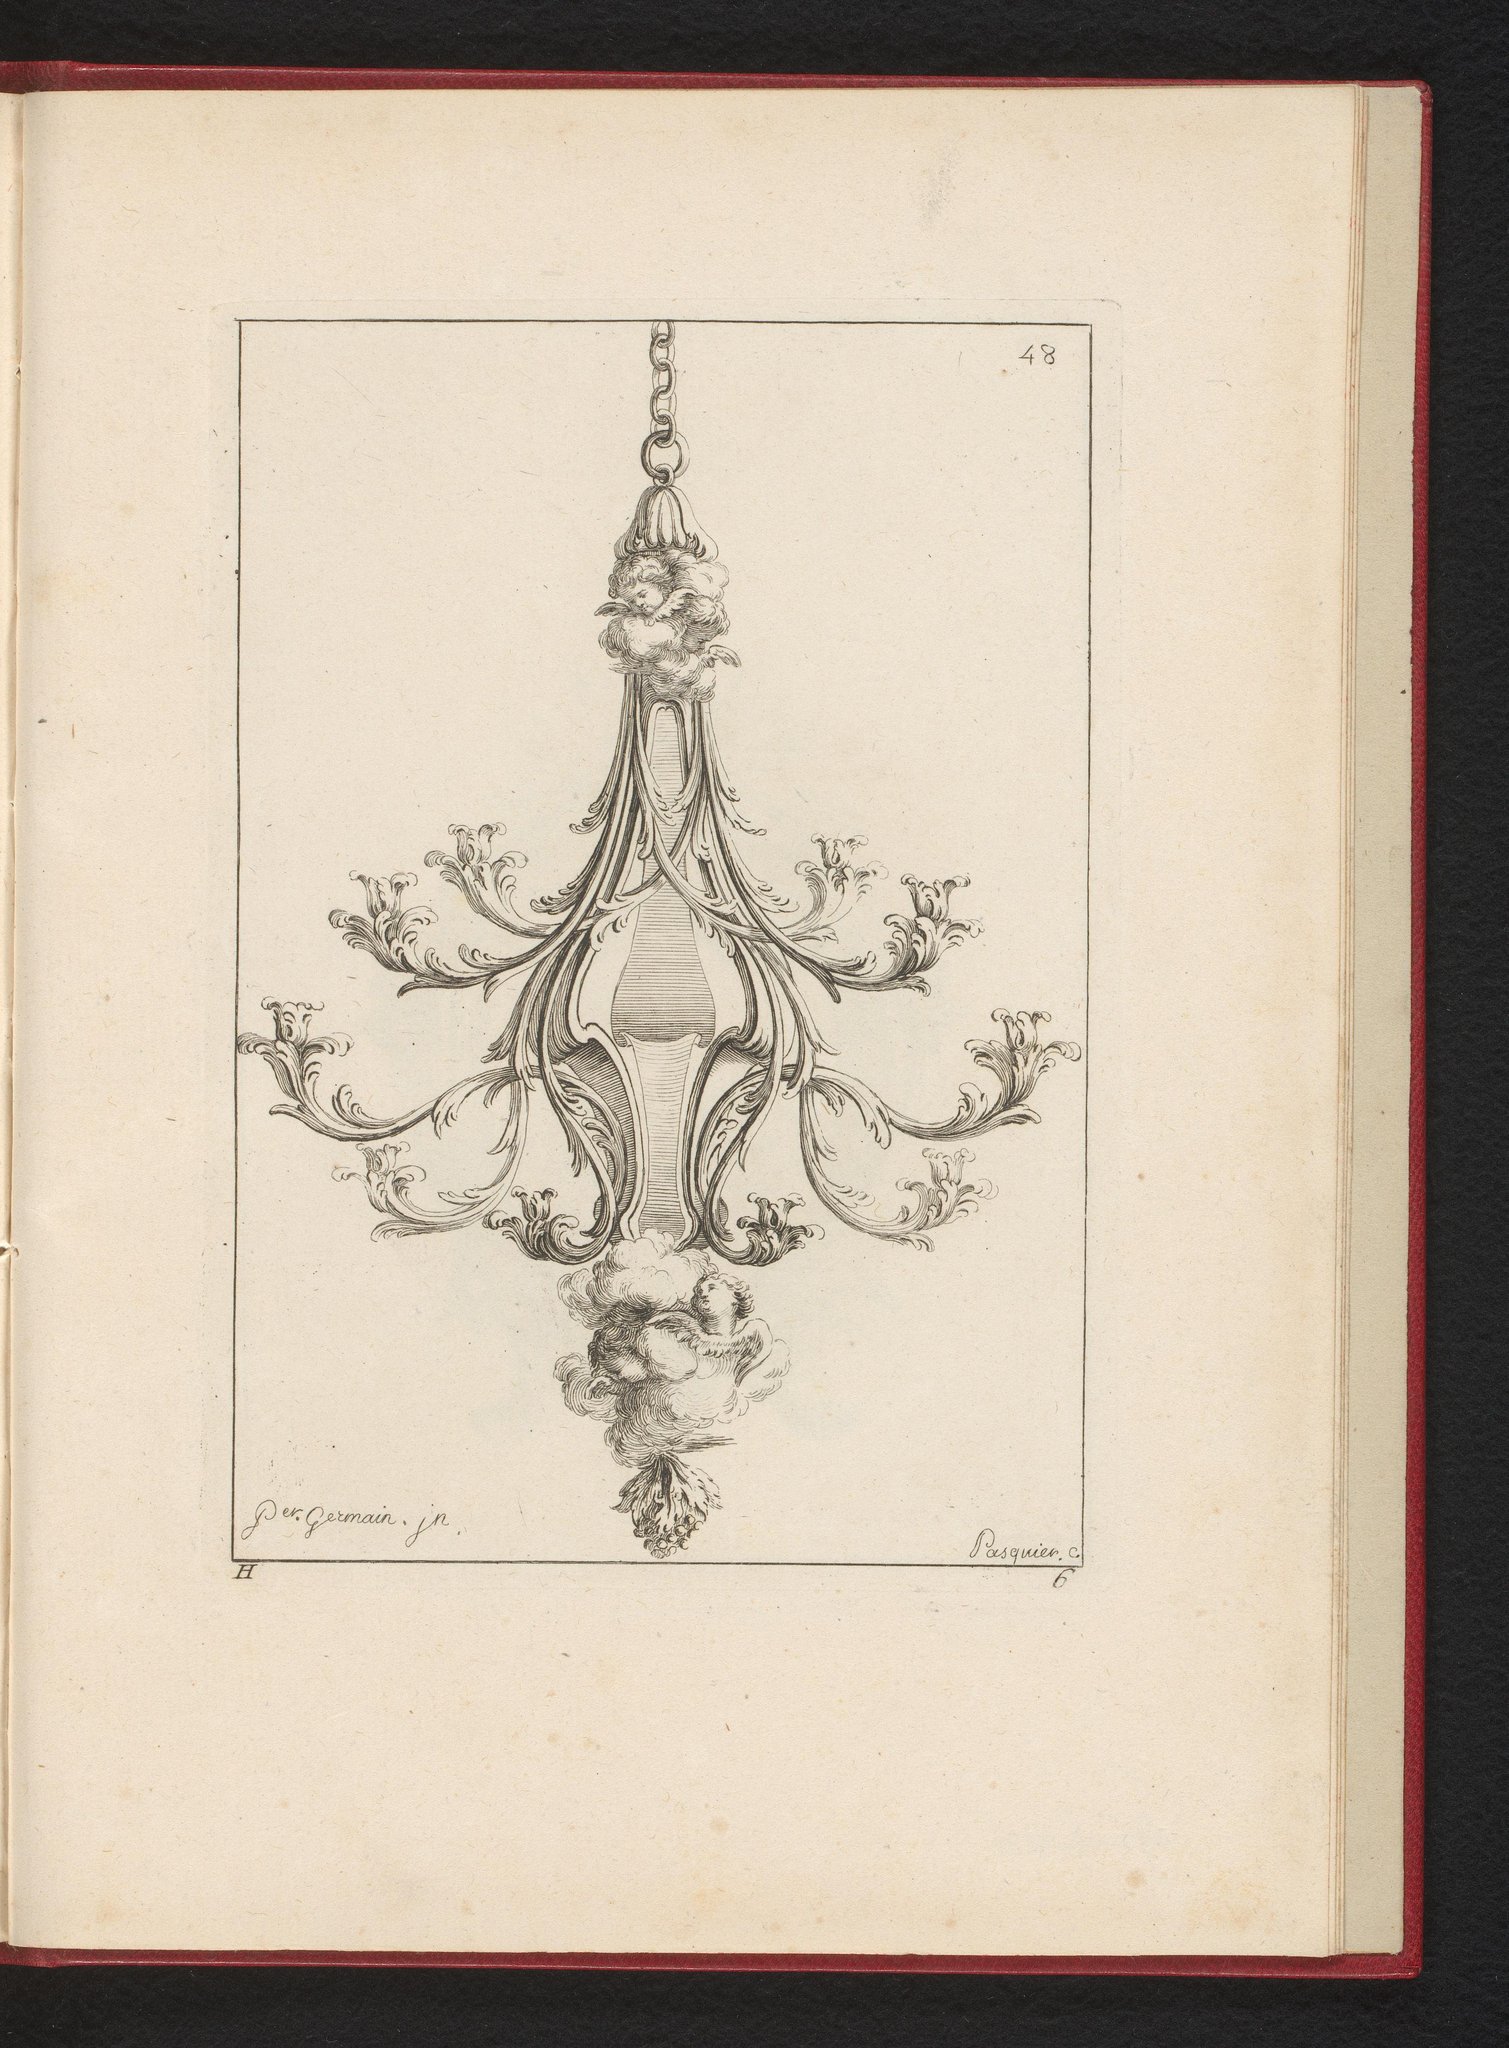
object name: album leaf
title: Ontwerp voor een kroonluchter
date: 1748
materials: paper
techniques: etching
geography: paris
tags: chandelier, candelabrum, jeweller, goldsmith, silversmith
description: Deze prent maakt deel uit van een album.